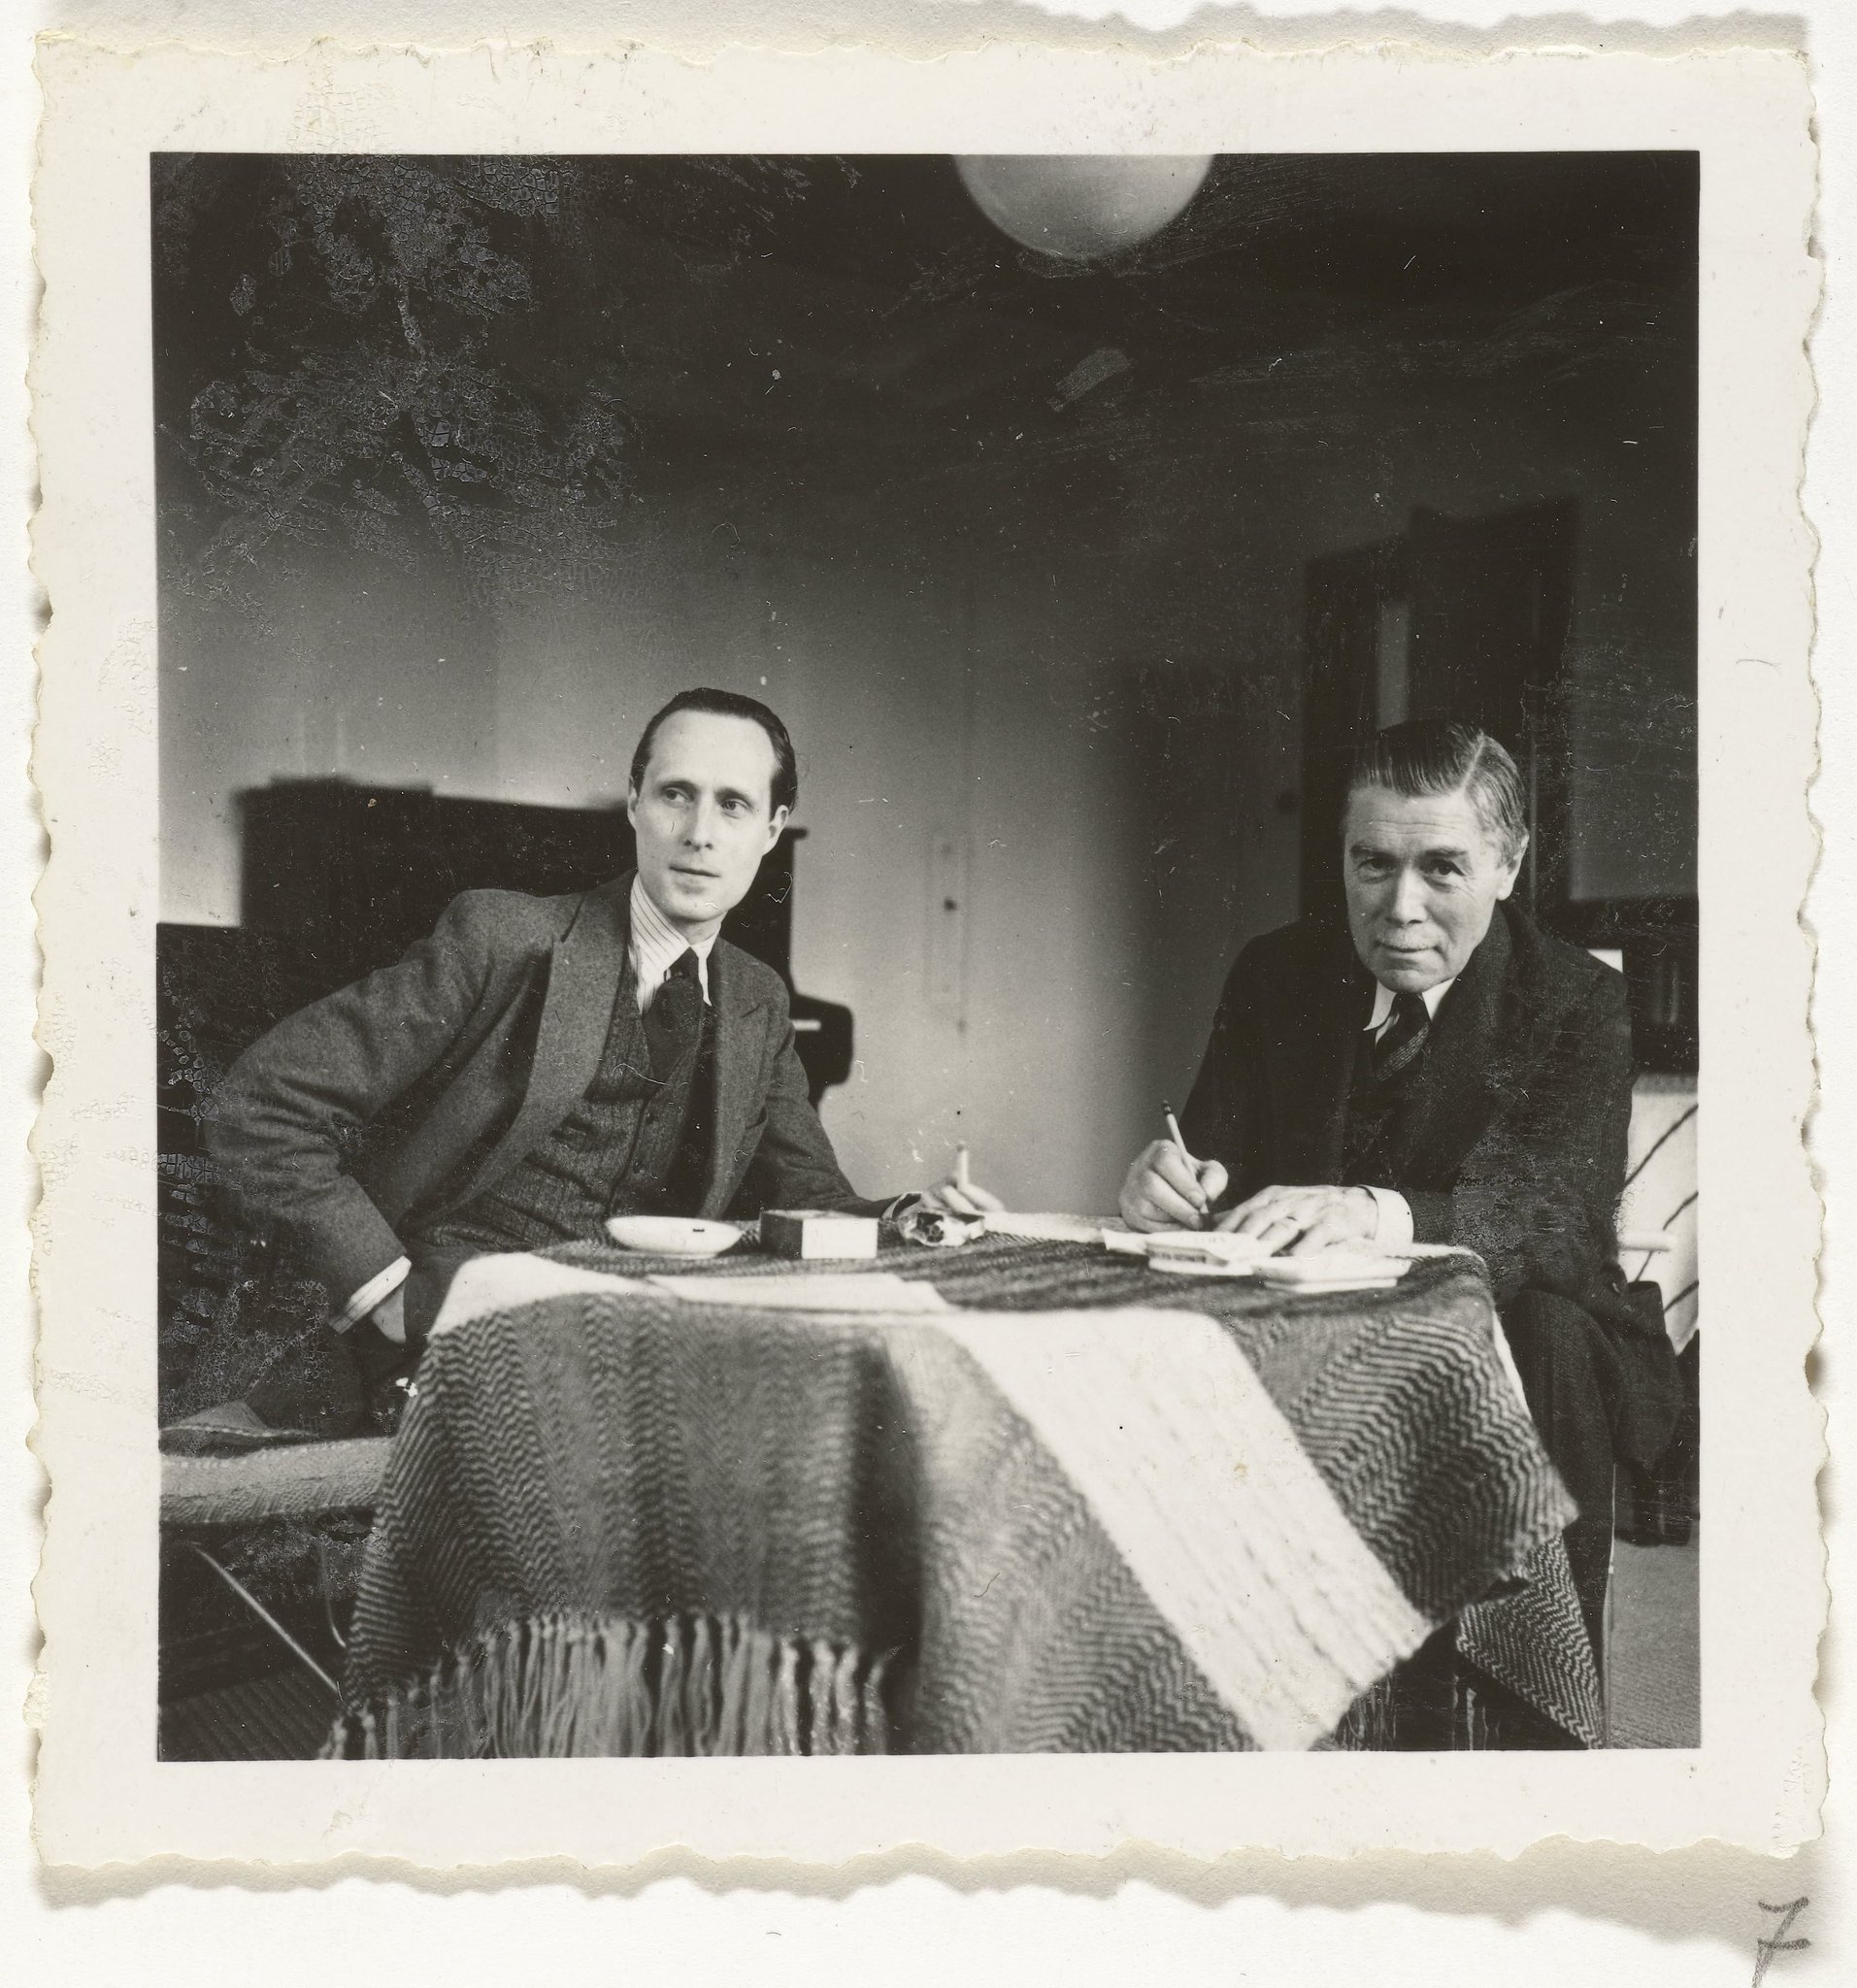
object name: photograph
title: Portret van Carel Willink en A.M. Hammacher aan tafel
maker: Anonymous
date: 1930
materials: paper, photographic support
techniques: gelatin silver print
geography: netherlands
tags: amsterdam, print maker, draughtsman, carel willink, historical persons (portraits and scenes from the life)